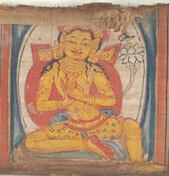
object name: folio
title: Bodhisattva Manjushri, Leaf from a dispersed Ashtasahasrika Prajnaparamita (Perfection of Wisdom) Manuscript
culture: indian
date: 1101-1200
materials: ink, leaf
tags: buddhism,bodhisattvas,manjushri